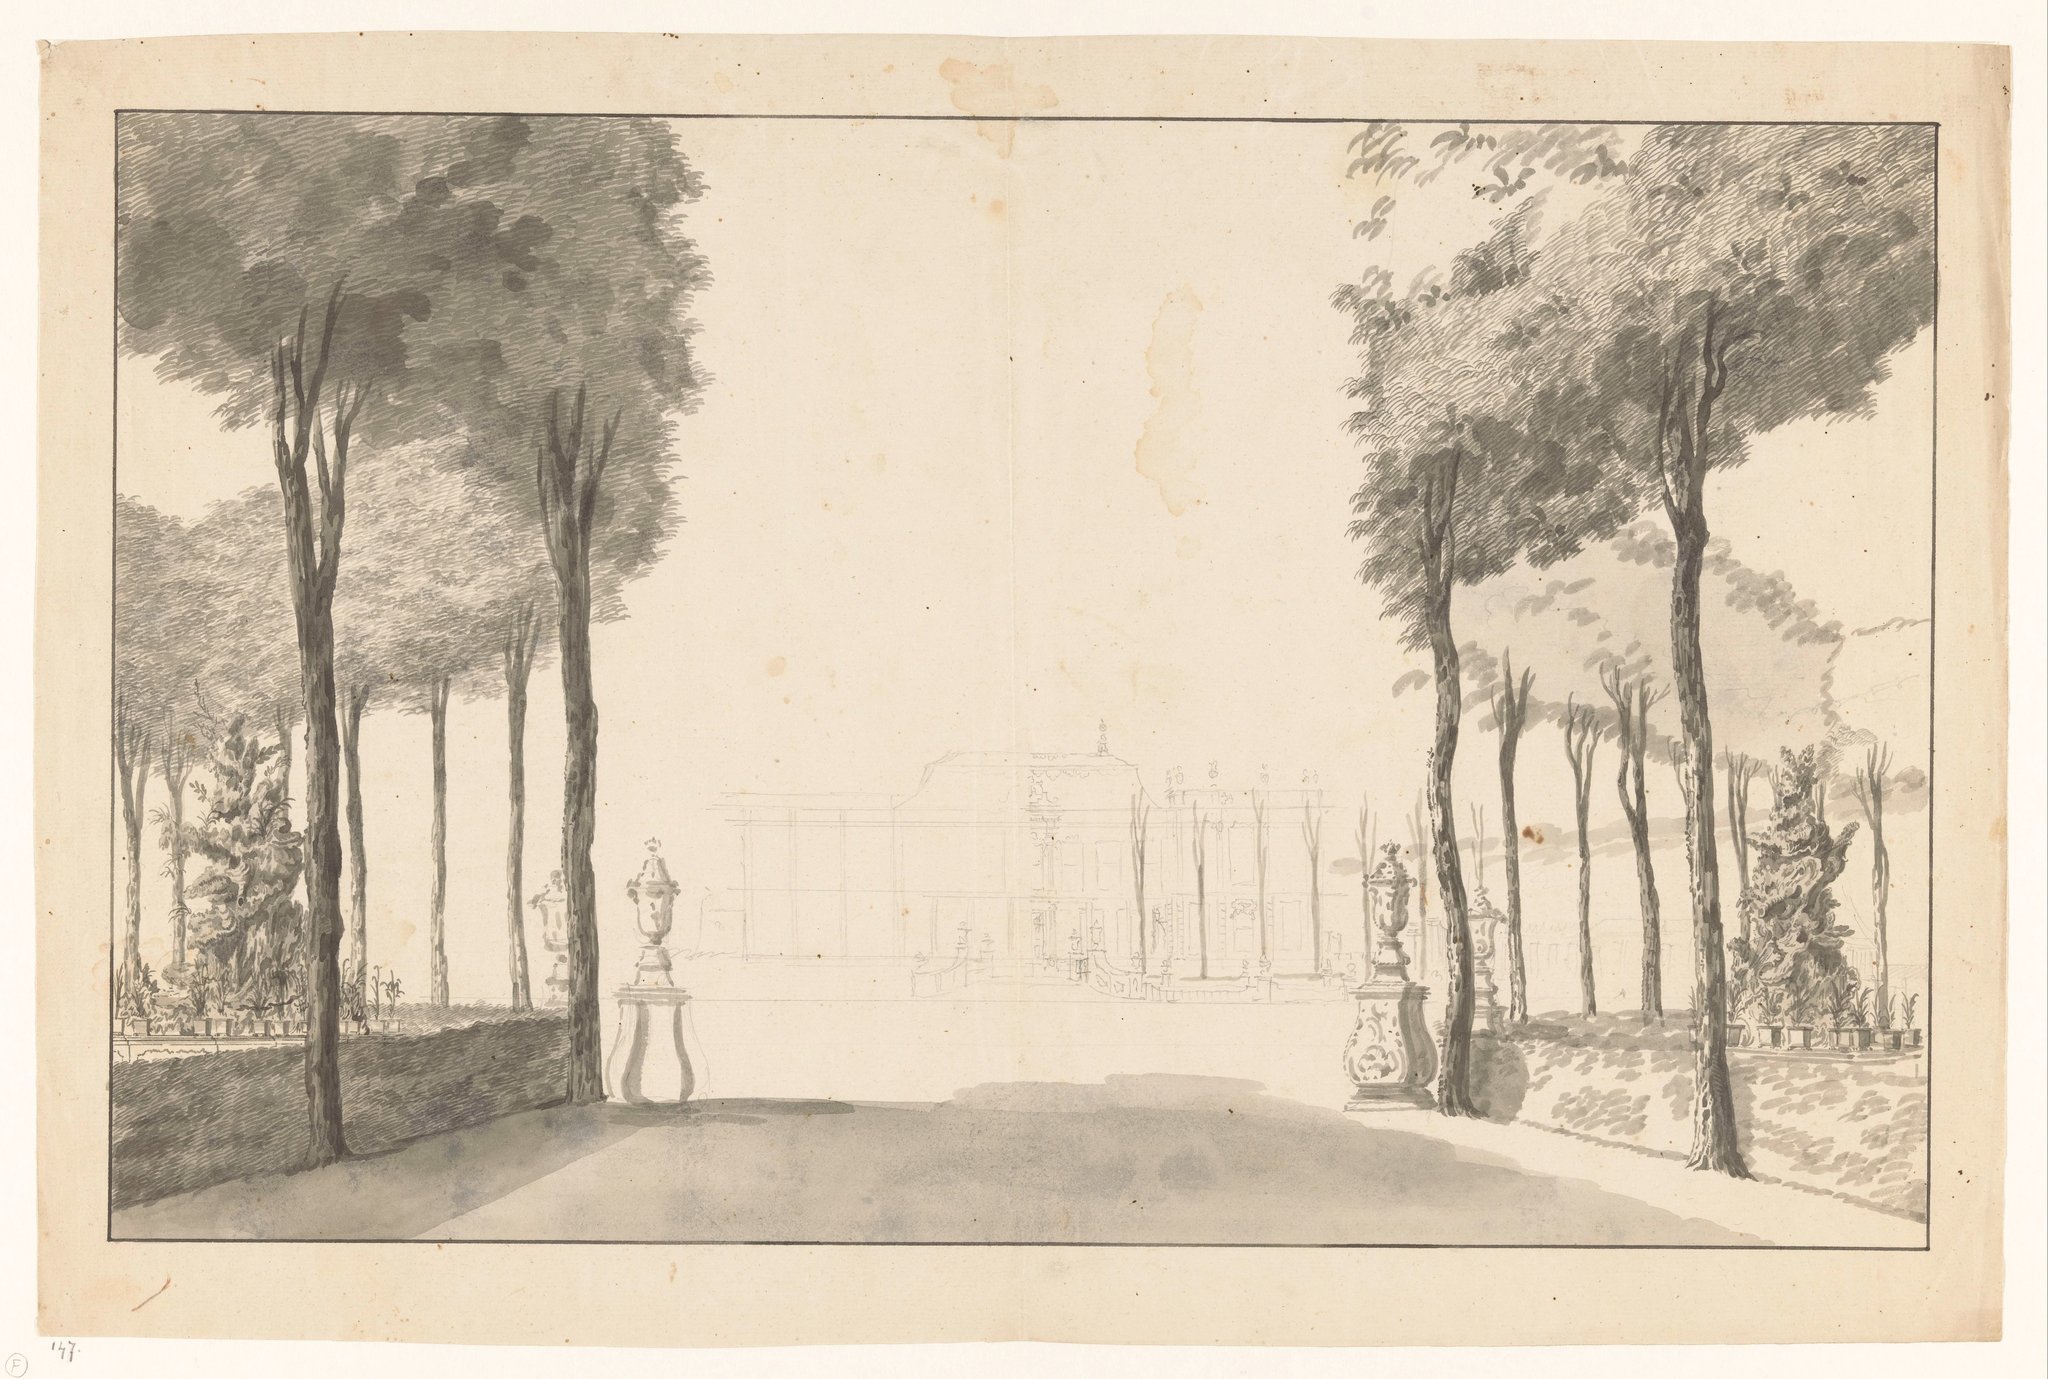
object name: drawing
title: Landhuis te Batavia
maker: jan brandes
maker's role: draughtsman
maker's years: 1743-1808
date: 1779-1785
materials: paper, pencil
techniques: brush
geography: batavia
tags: detached house in city, batavia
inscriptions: inscription: ‘Maison de Mr harkoofs fabrique’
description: Gezicht op een groot landhuis te Batavia vanaf de oprijlaan die wordt geflankeerd door grote sierpotten.